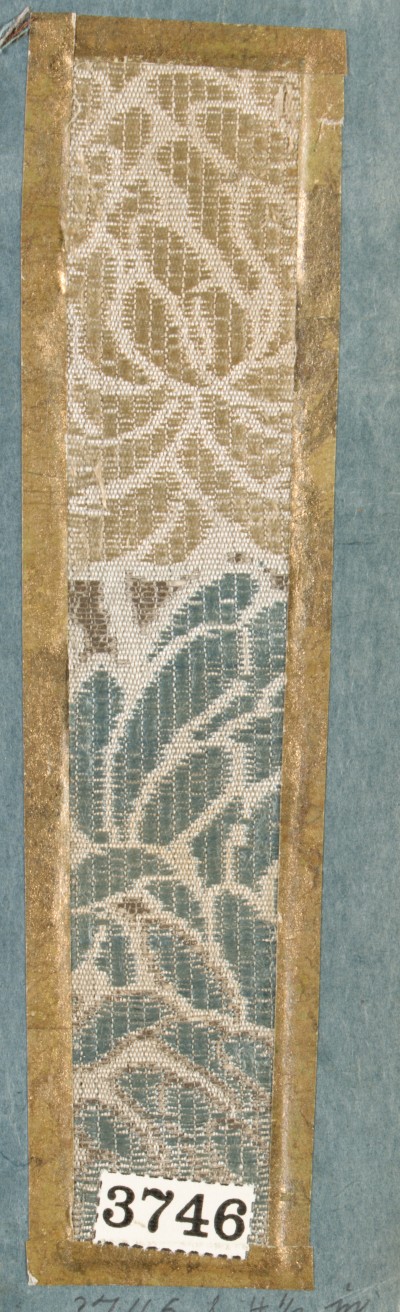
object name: sample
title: Textile Sample from Sample Book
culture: japanese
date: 1801-1900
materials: silk